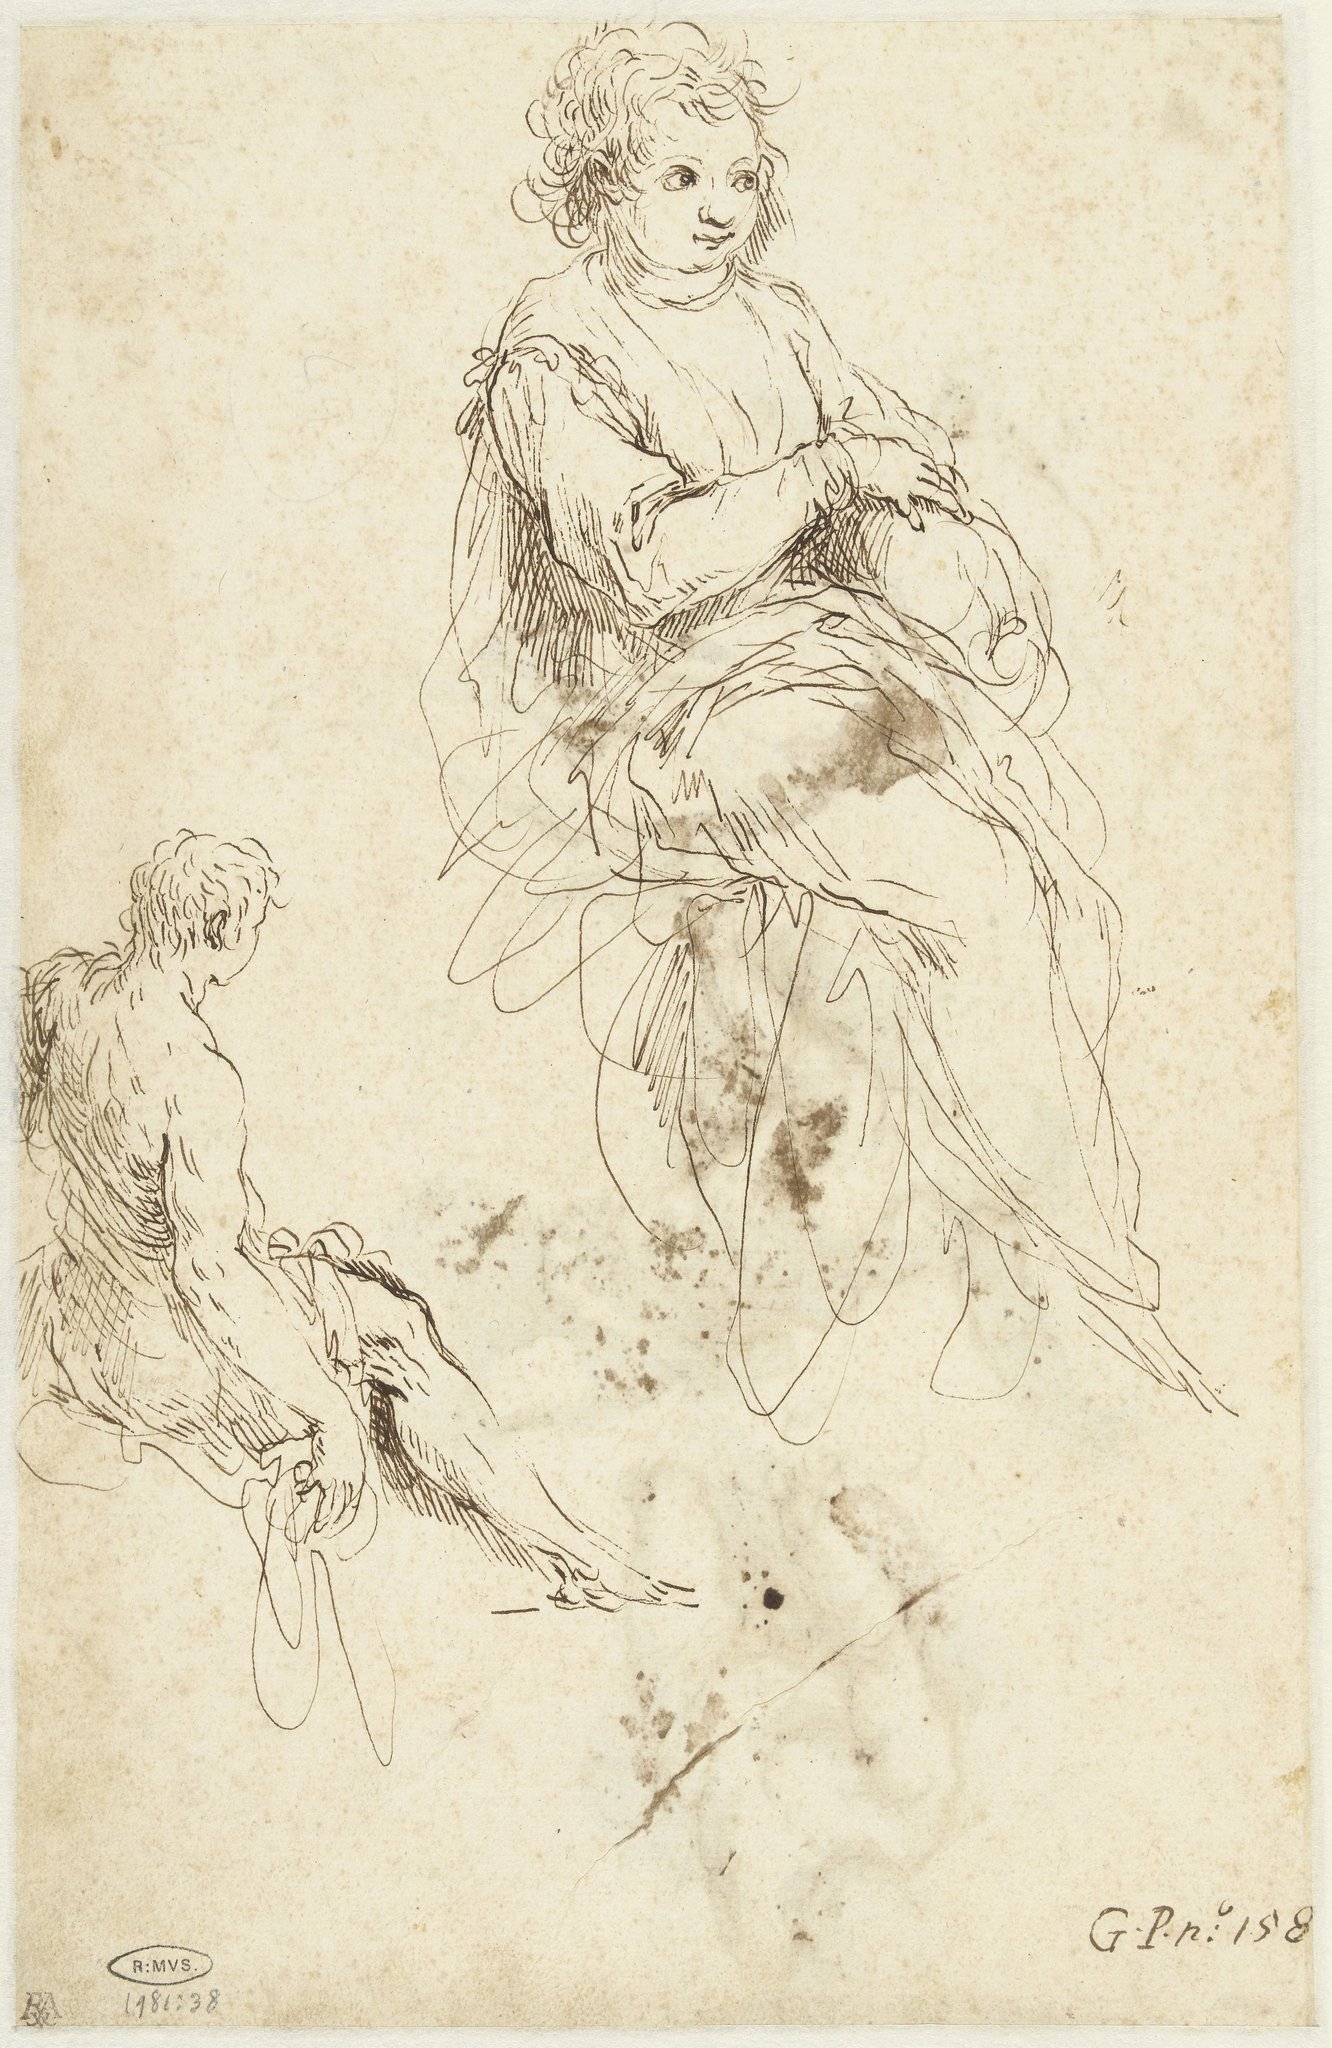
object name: drawing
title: Zittend kind en een jeugdige Johannes de Doper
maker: jacopo palma (il giovane)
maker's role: draughtsman, painter, print maker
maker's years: 1544-1628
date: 1587-1594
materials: ink, paper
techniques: pen